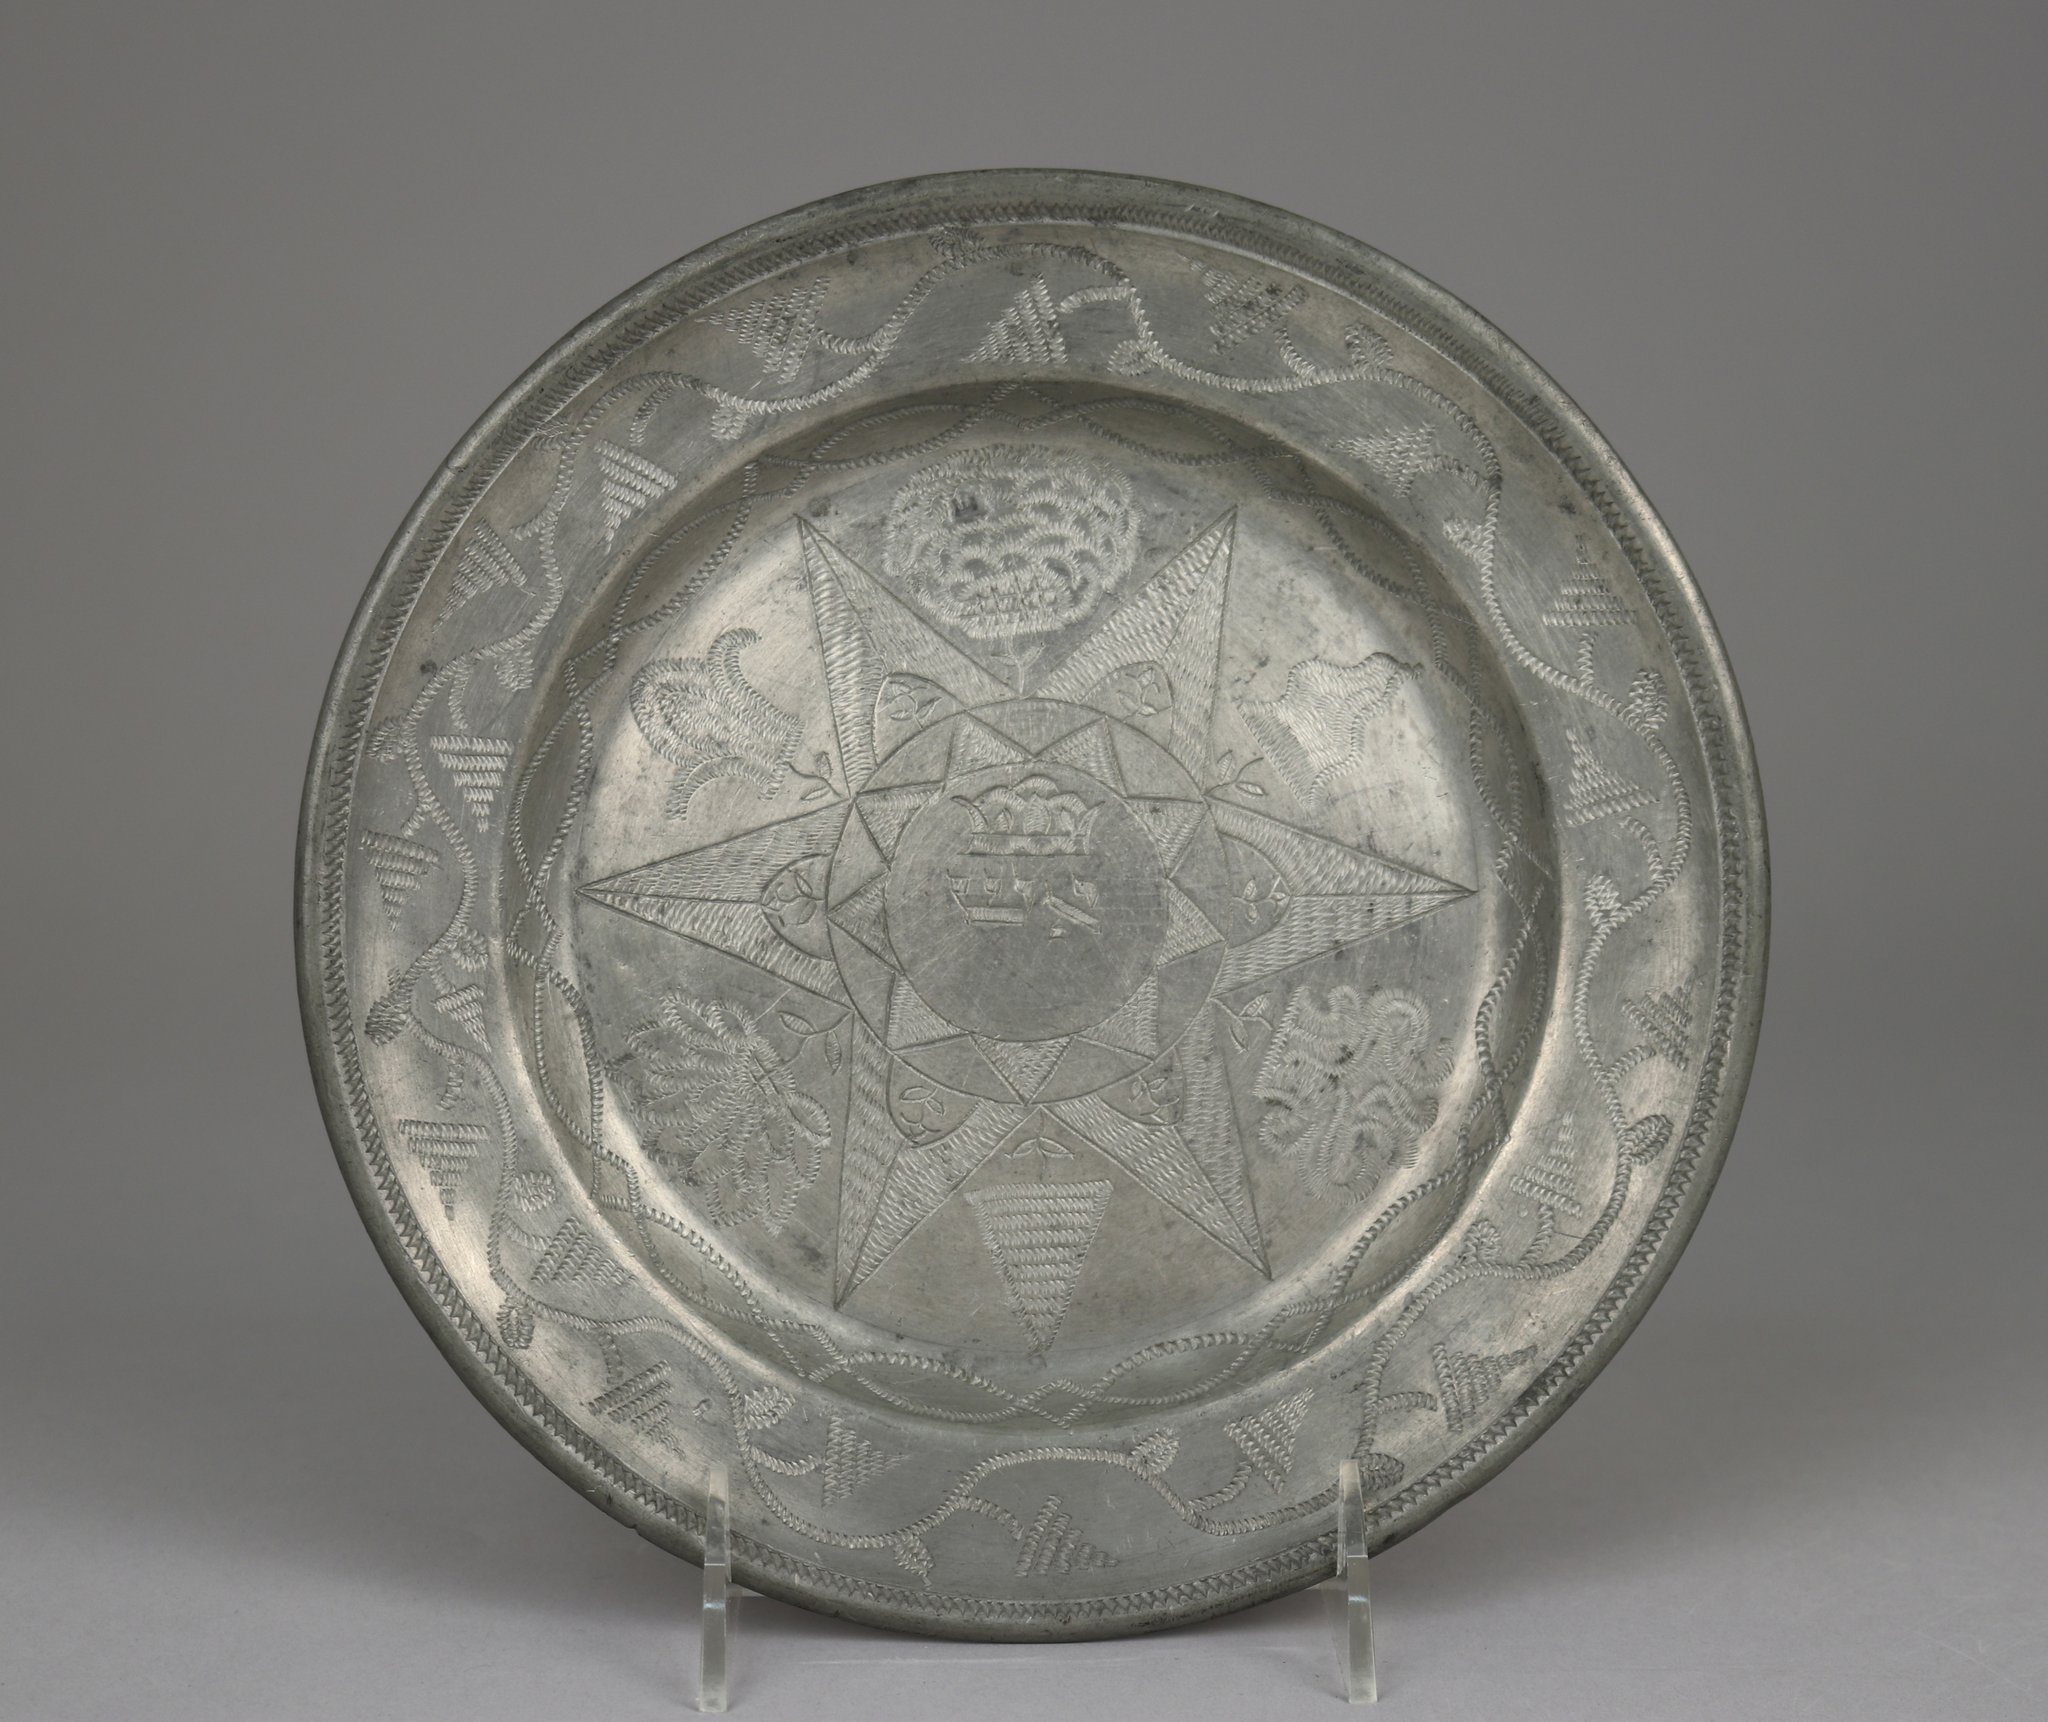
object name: plate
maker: i. a. s. ii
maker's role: maker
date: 1701-1800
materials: pewter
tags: flowers